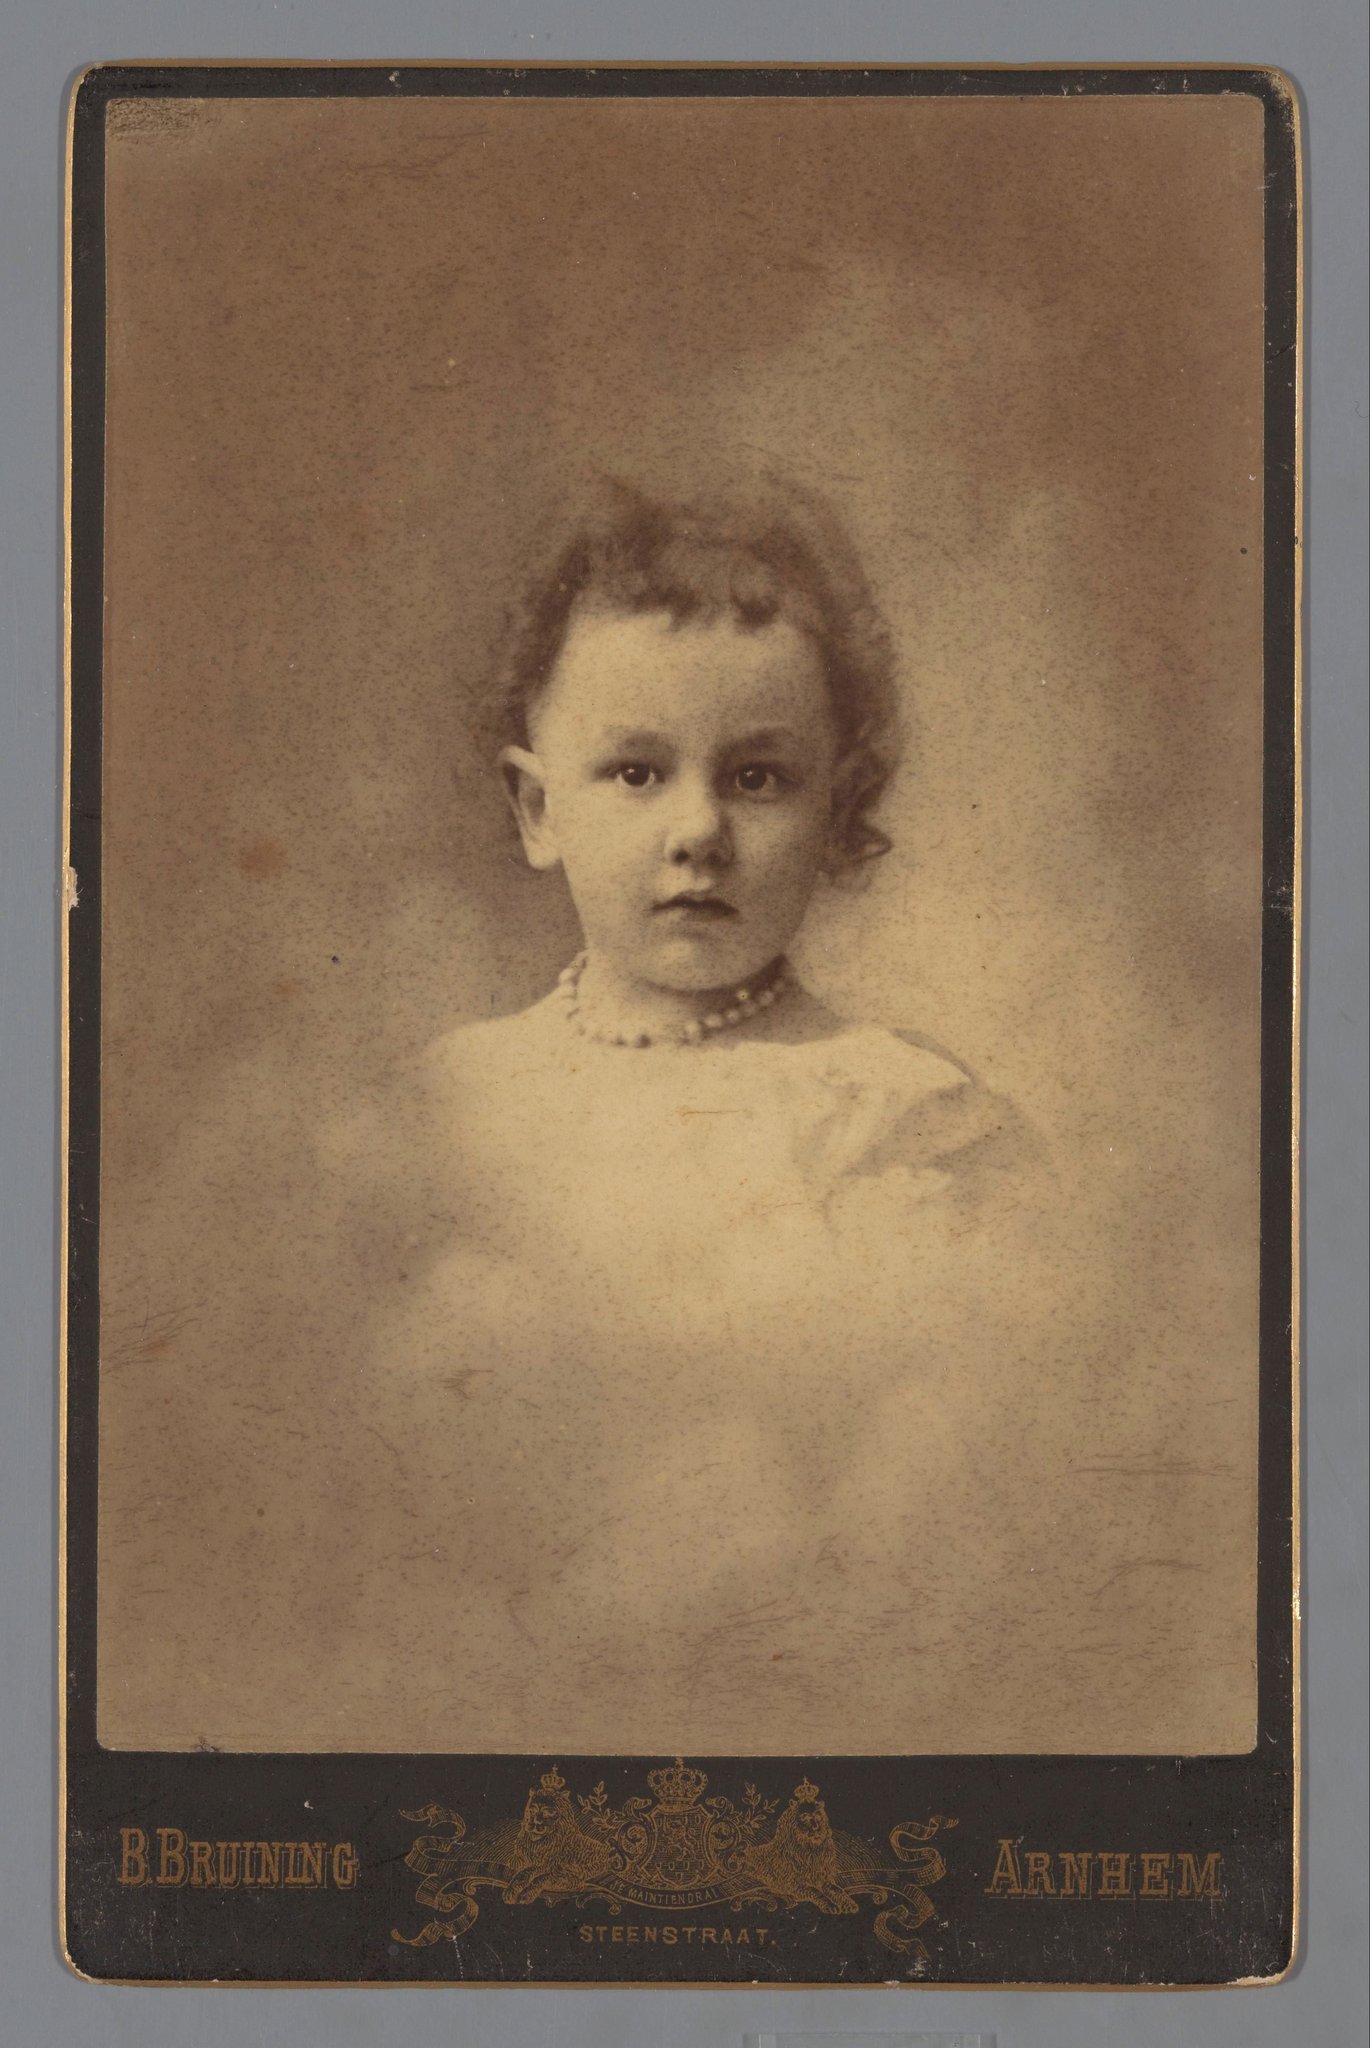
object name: cabinet photograph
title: Portret van een onbekend meisje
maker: bernardus bruining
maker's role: fotograaf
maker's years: 1834-1900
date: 1880-1890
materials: cardboard, photographic support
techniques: albumen print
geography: arnhem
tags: child (at home) - aa - girl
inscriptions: name: ‘B. Bruining Arnhem Steenstraat.’